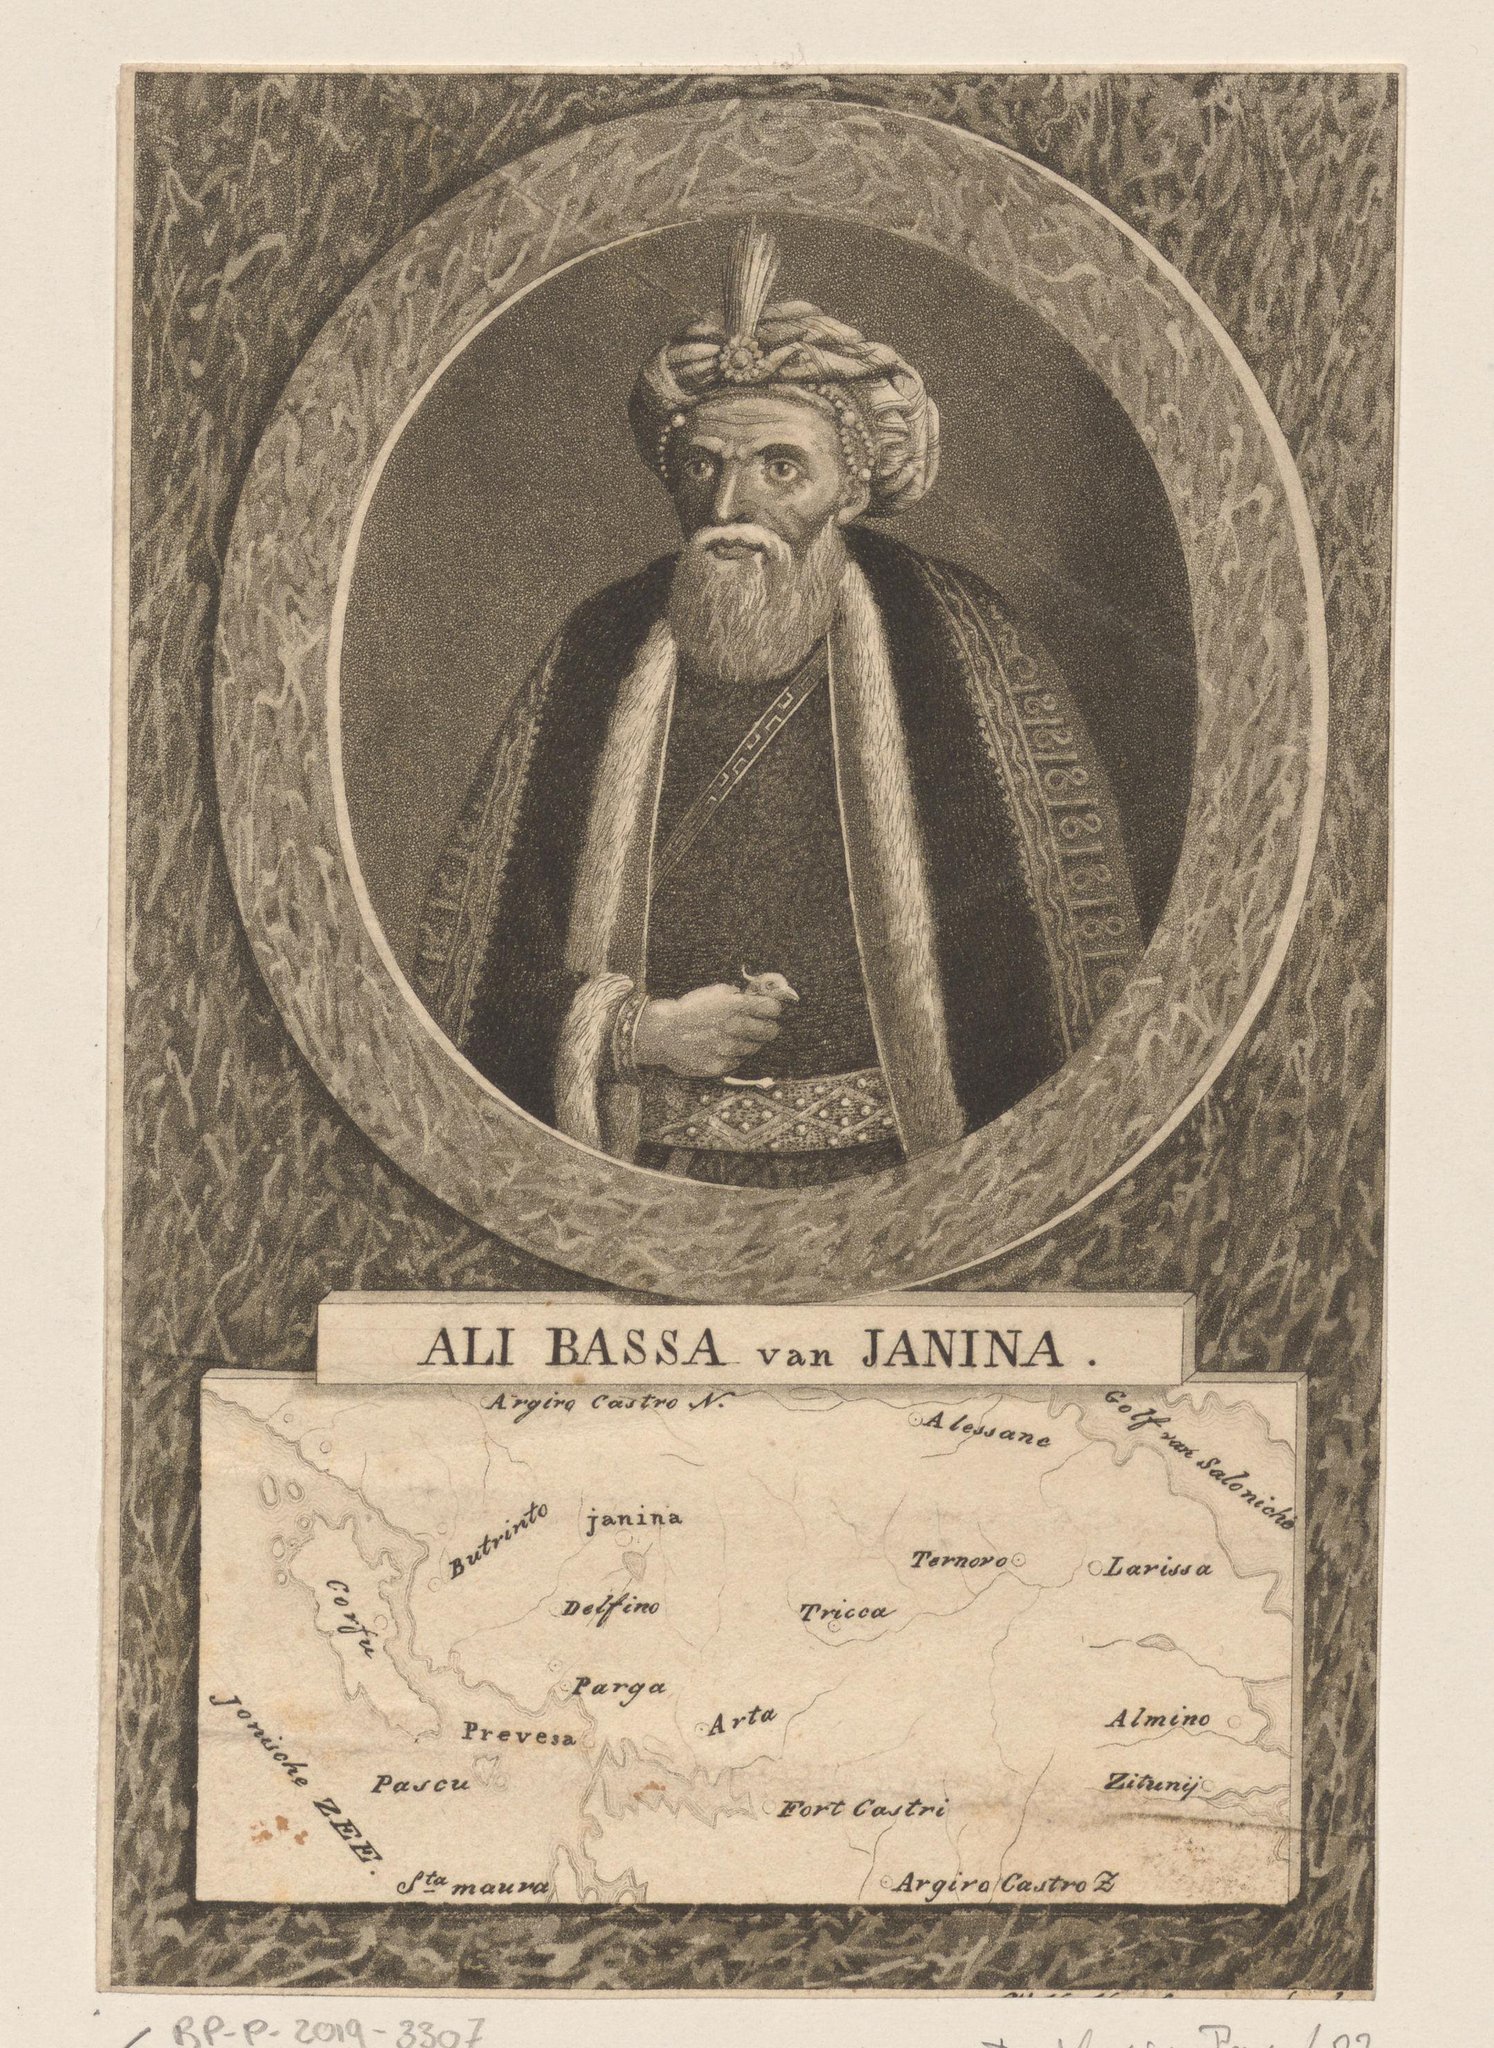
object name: print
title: Portret van Ali, pasja van Ioannina, met kaart van de Balkan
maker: Anonymous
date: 1800-1849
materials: paper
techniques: aquatint, etching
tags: maps of separate countries or regions, historical persons, head-gear: turban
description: Rechtsonder waarschijnlijk gesigneerd, weggesneden.